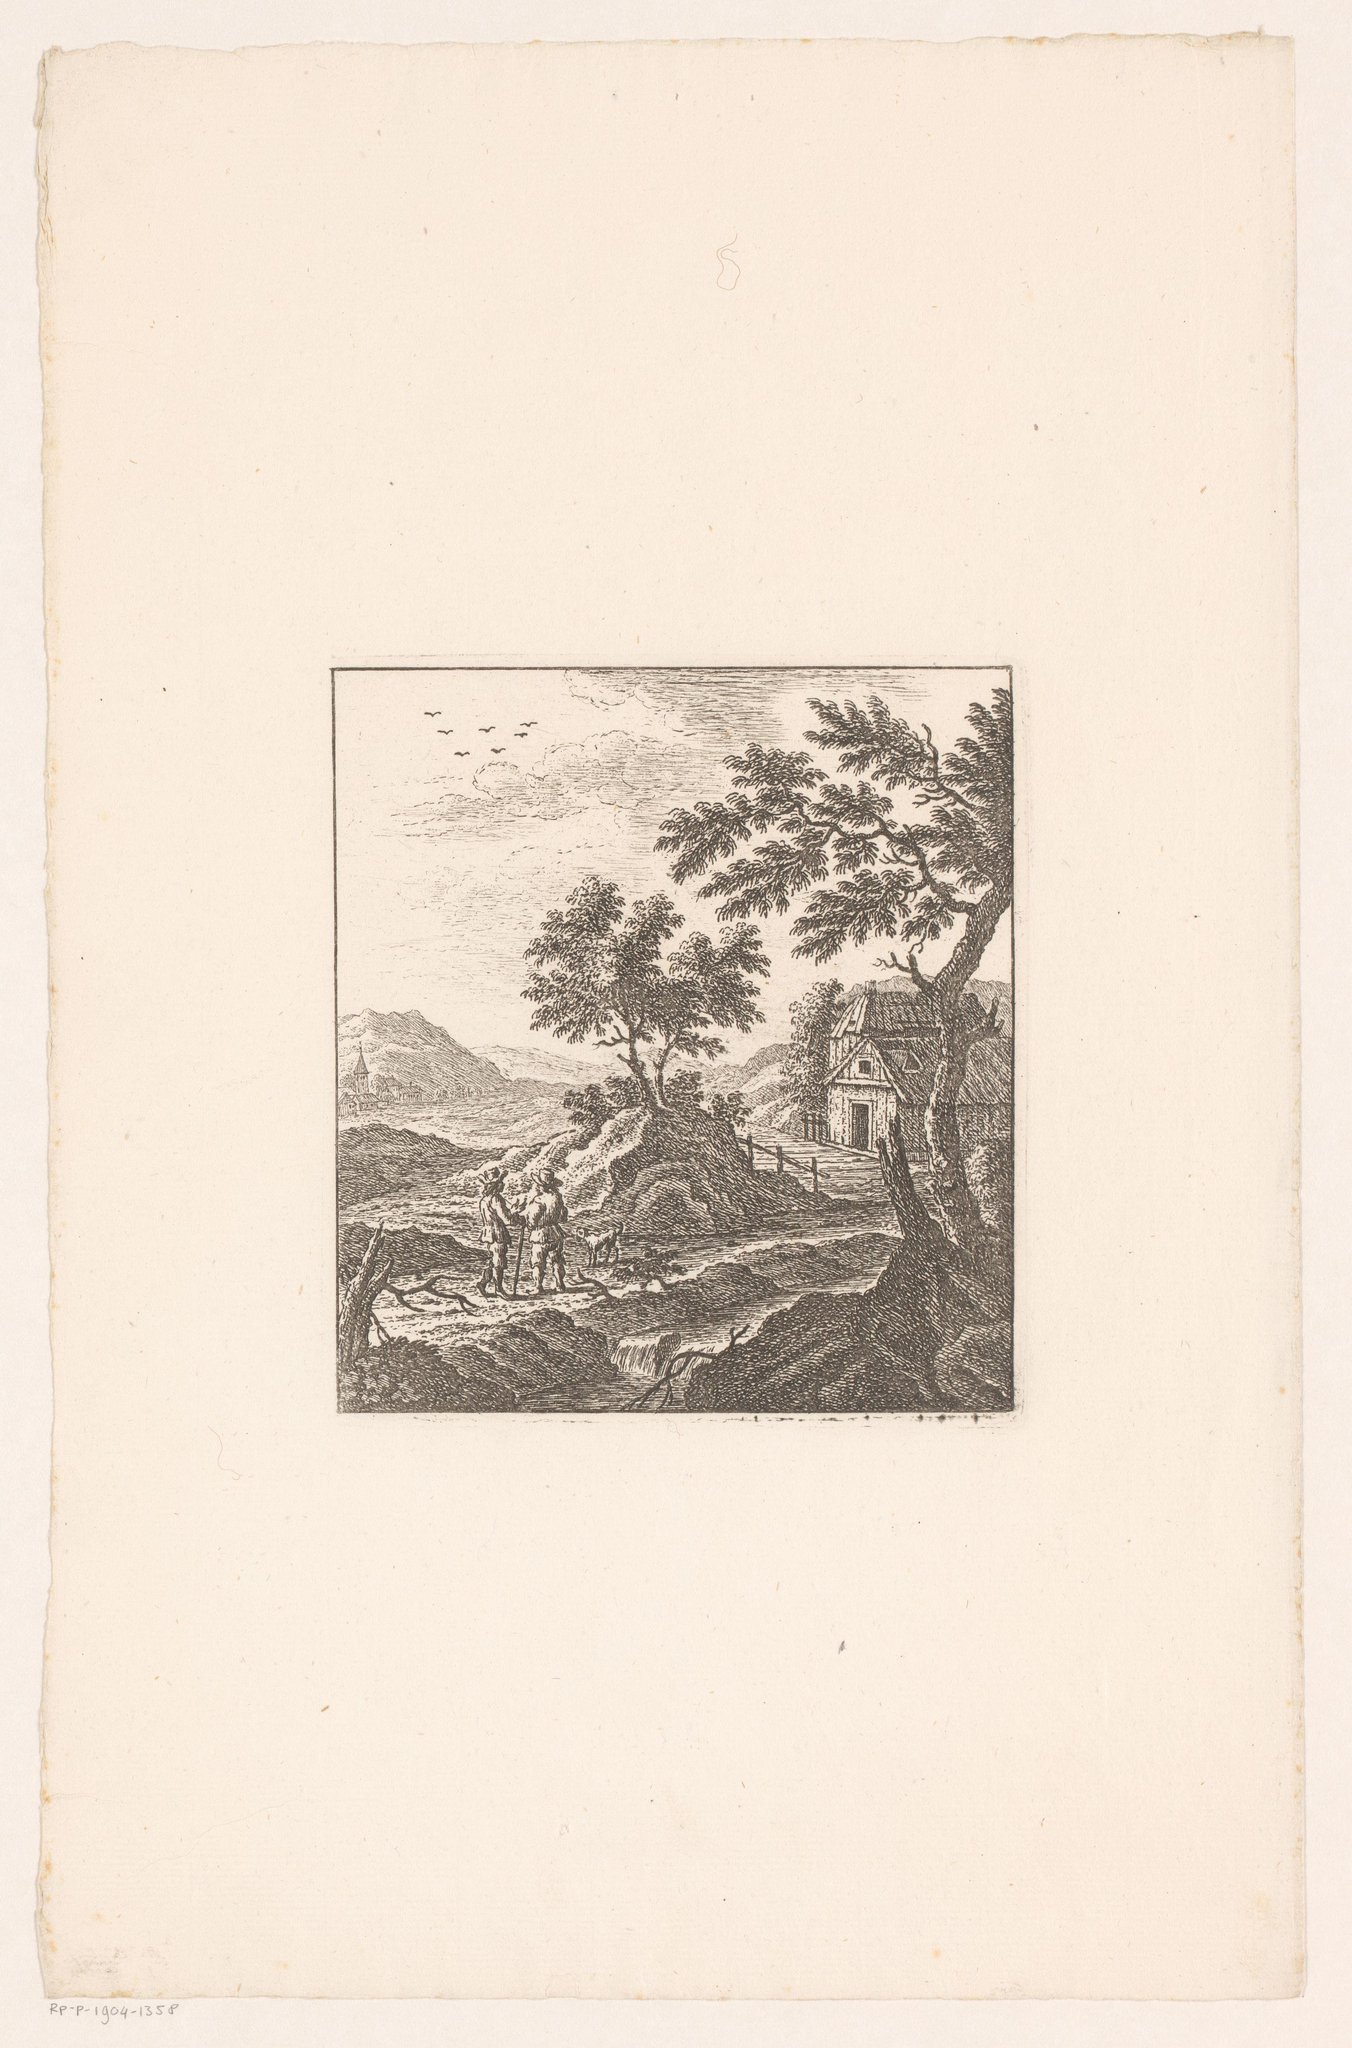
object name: print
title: Landschap met twee mannen en een hond bij een boerderij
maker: johann caspar ulinger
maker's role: painter, print maker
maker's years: 1703-1768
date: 1713-1768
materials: paper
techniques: etching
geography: switzerland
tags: city-view, and landscape with man-made constructions, landscape with bridge, viaduct or aqueduct, 'en route', traveller under way, farm or solitary house in landscape, dog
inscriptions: collector's mark: Lugt 2228